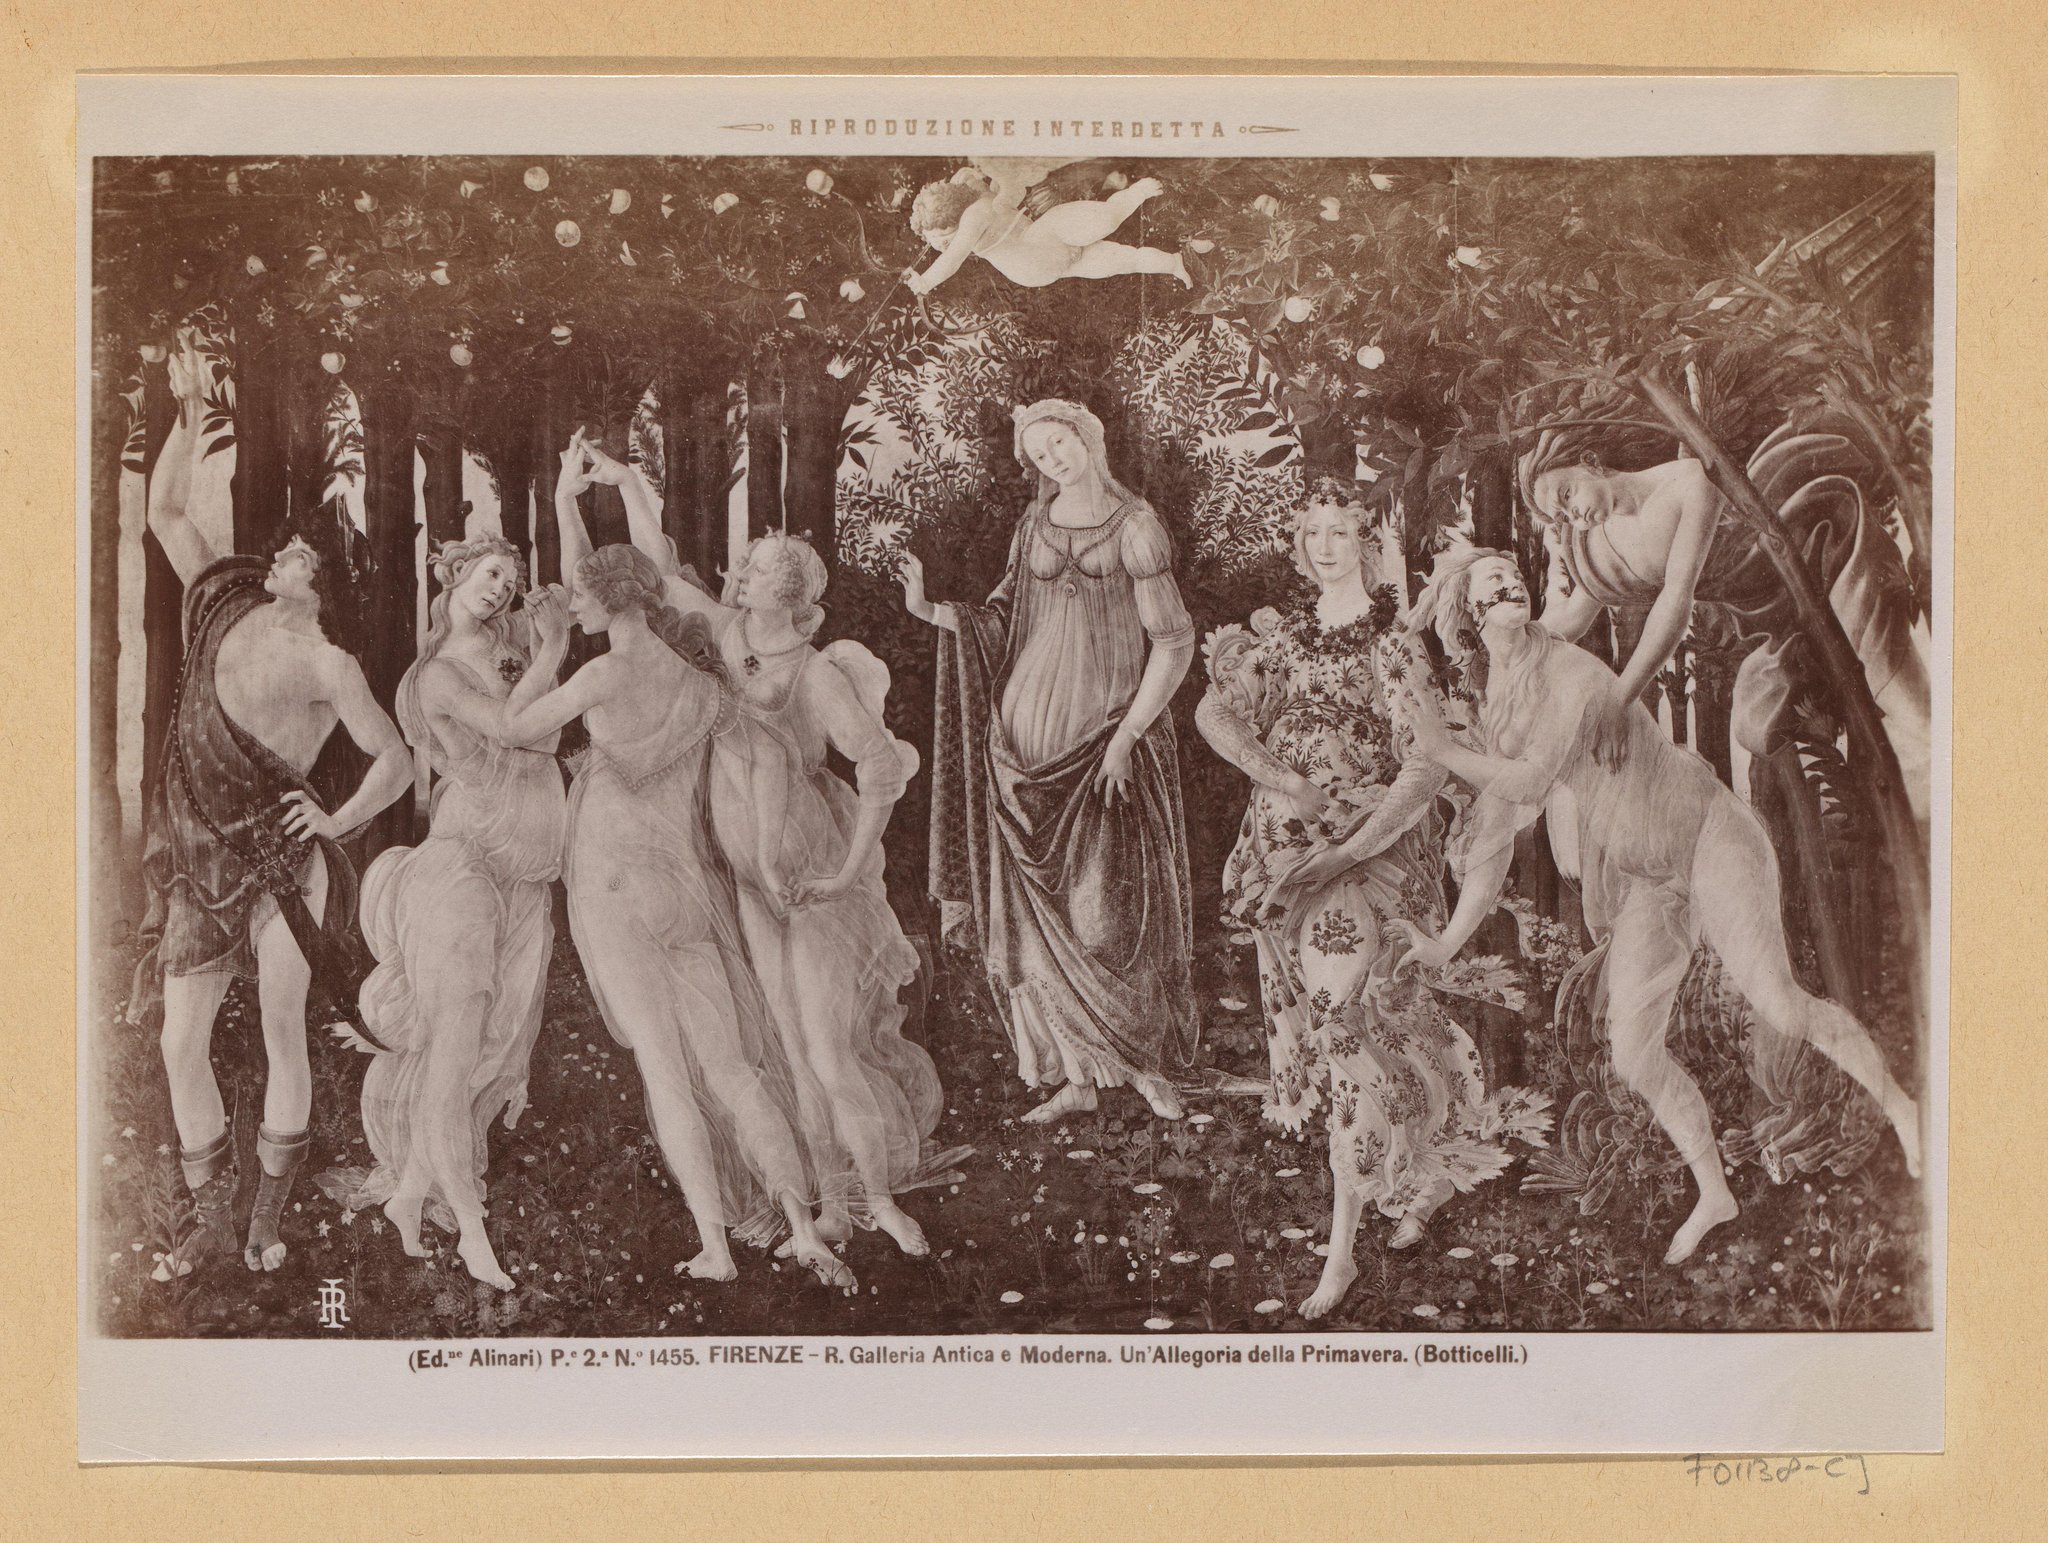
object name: photograph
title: Fotoreproductie van het schilderij La Primavera door Botticelli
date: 1860-1900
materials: photographic support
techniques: albumen print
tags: spring, 'ver'; 'primavera' (ripa)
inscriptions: inscription: ‘IR’, number: ‘Pe. 2a. No. 1455’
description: Onderdeel van Reisalbum met opnames van kunstwerken en bezienswaardigheden in Italië, Griekenland en Frankrijk.